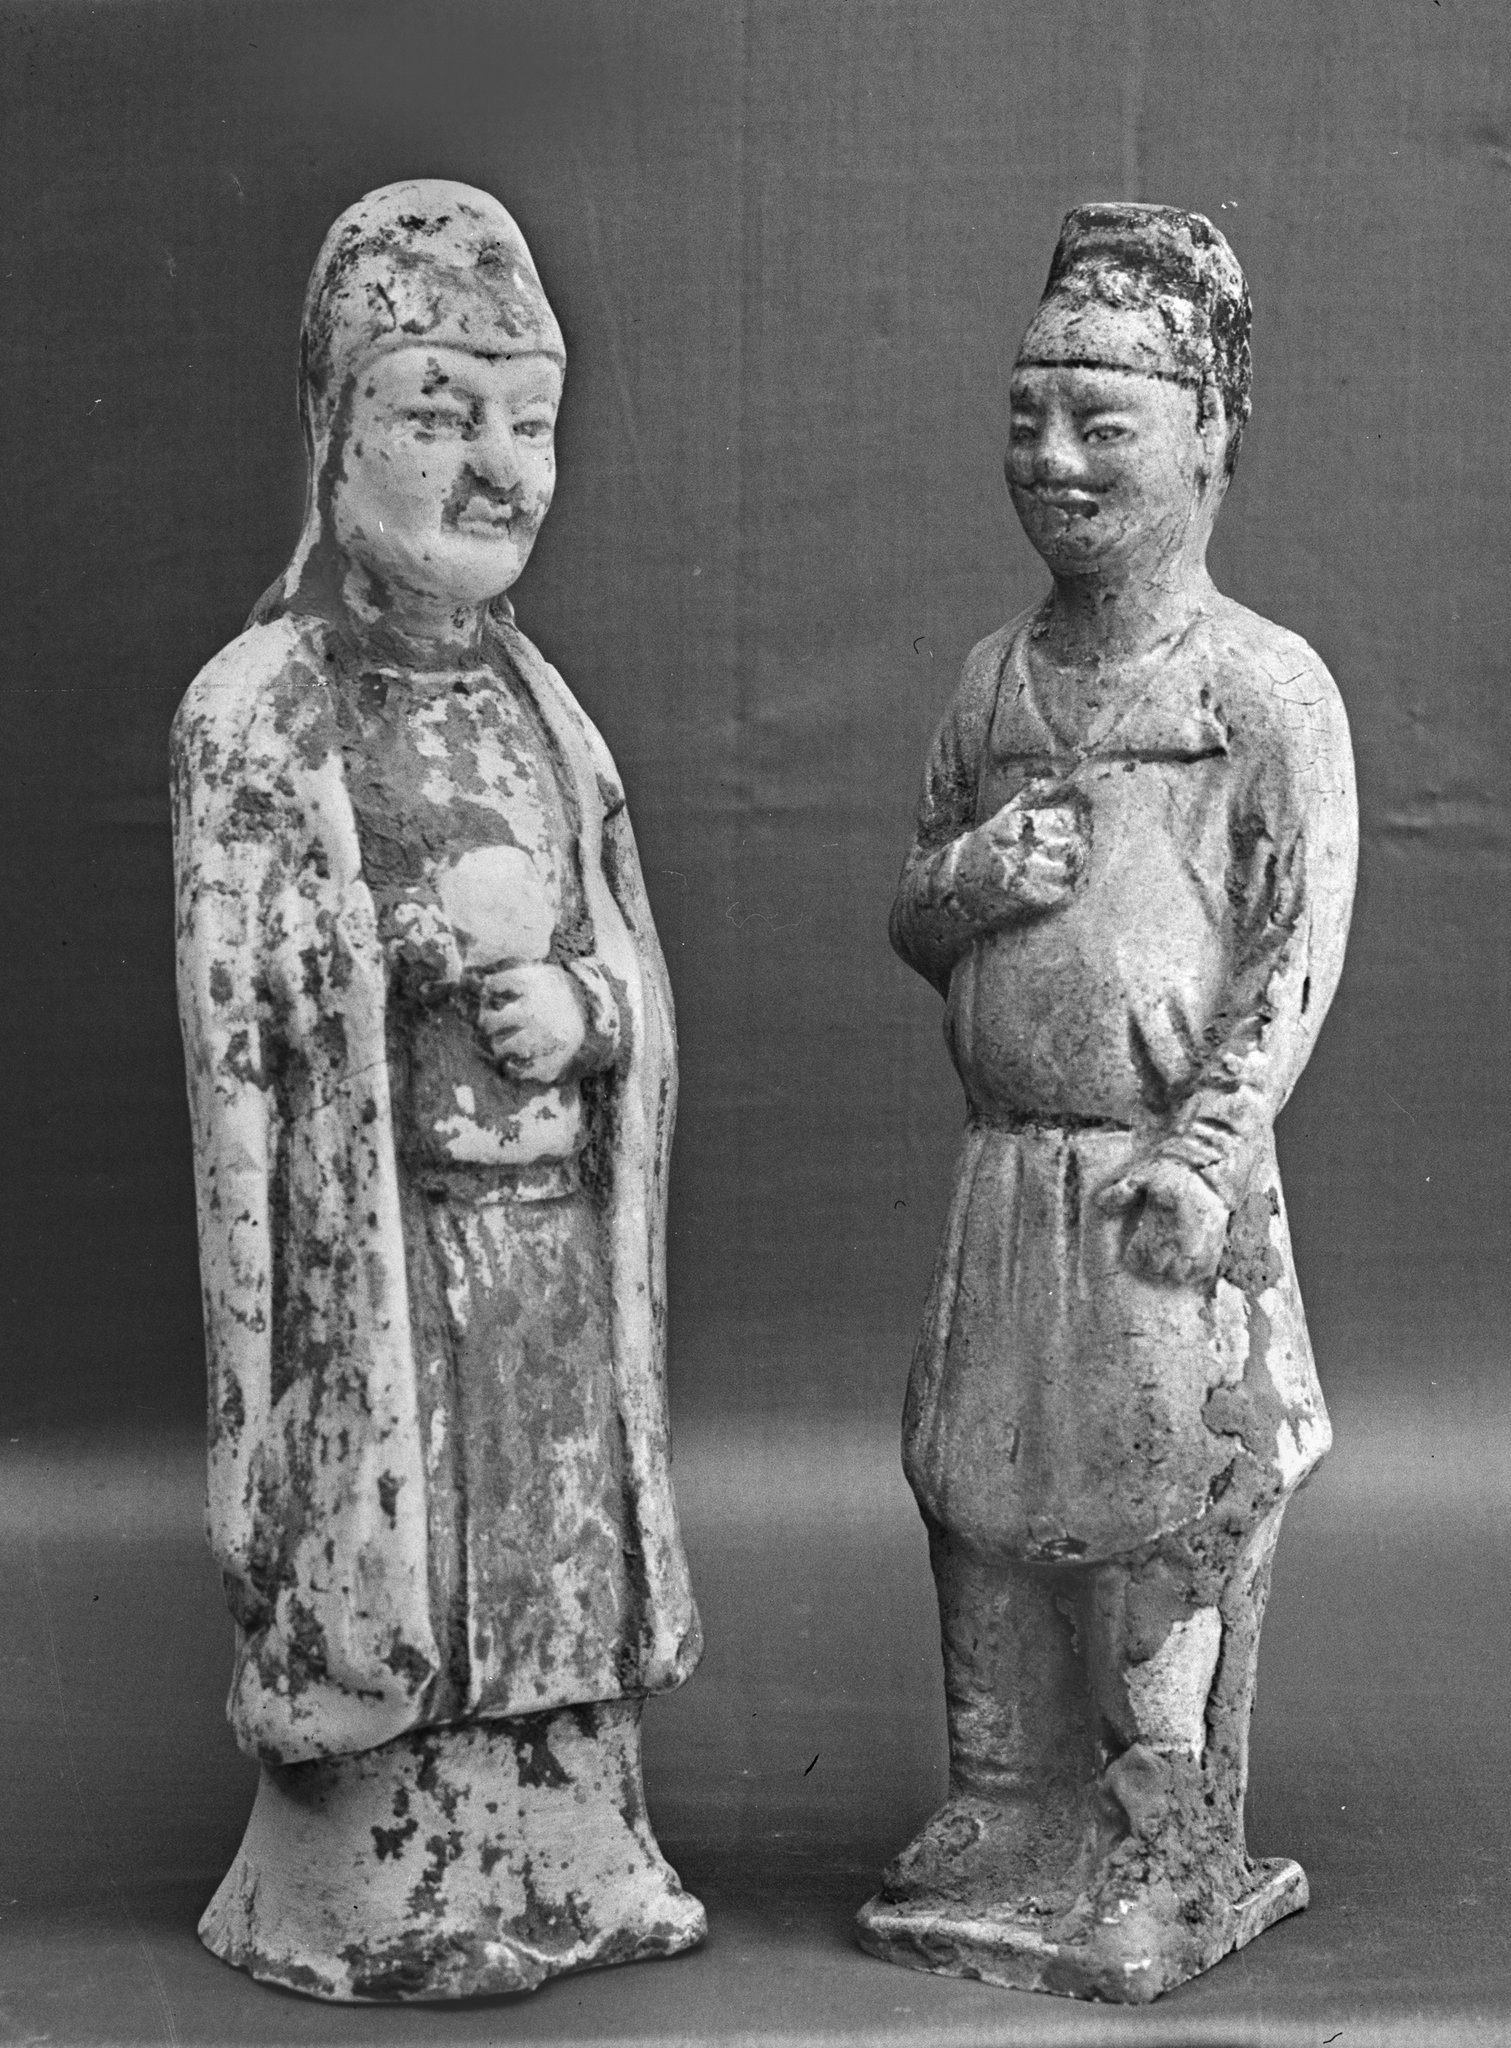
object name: figure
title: Figure of a standing man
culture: chinese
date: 601-800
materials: earthenware, pigment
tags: men